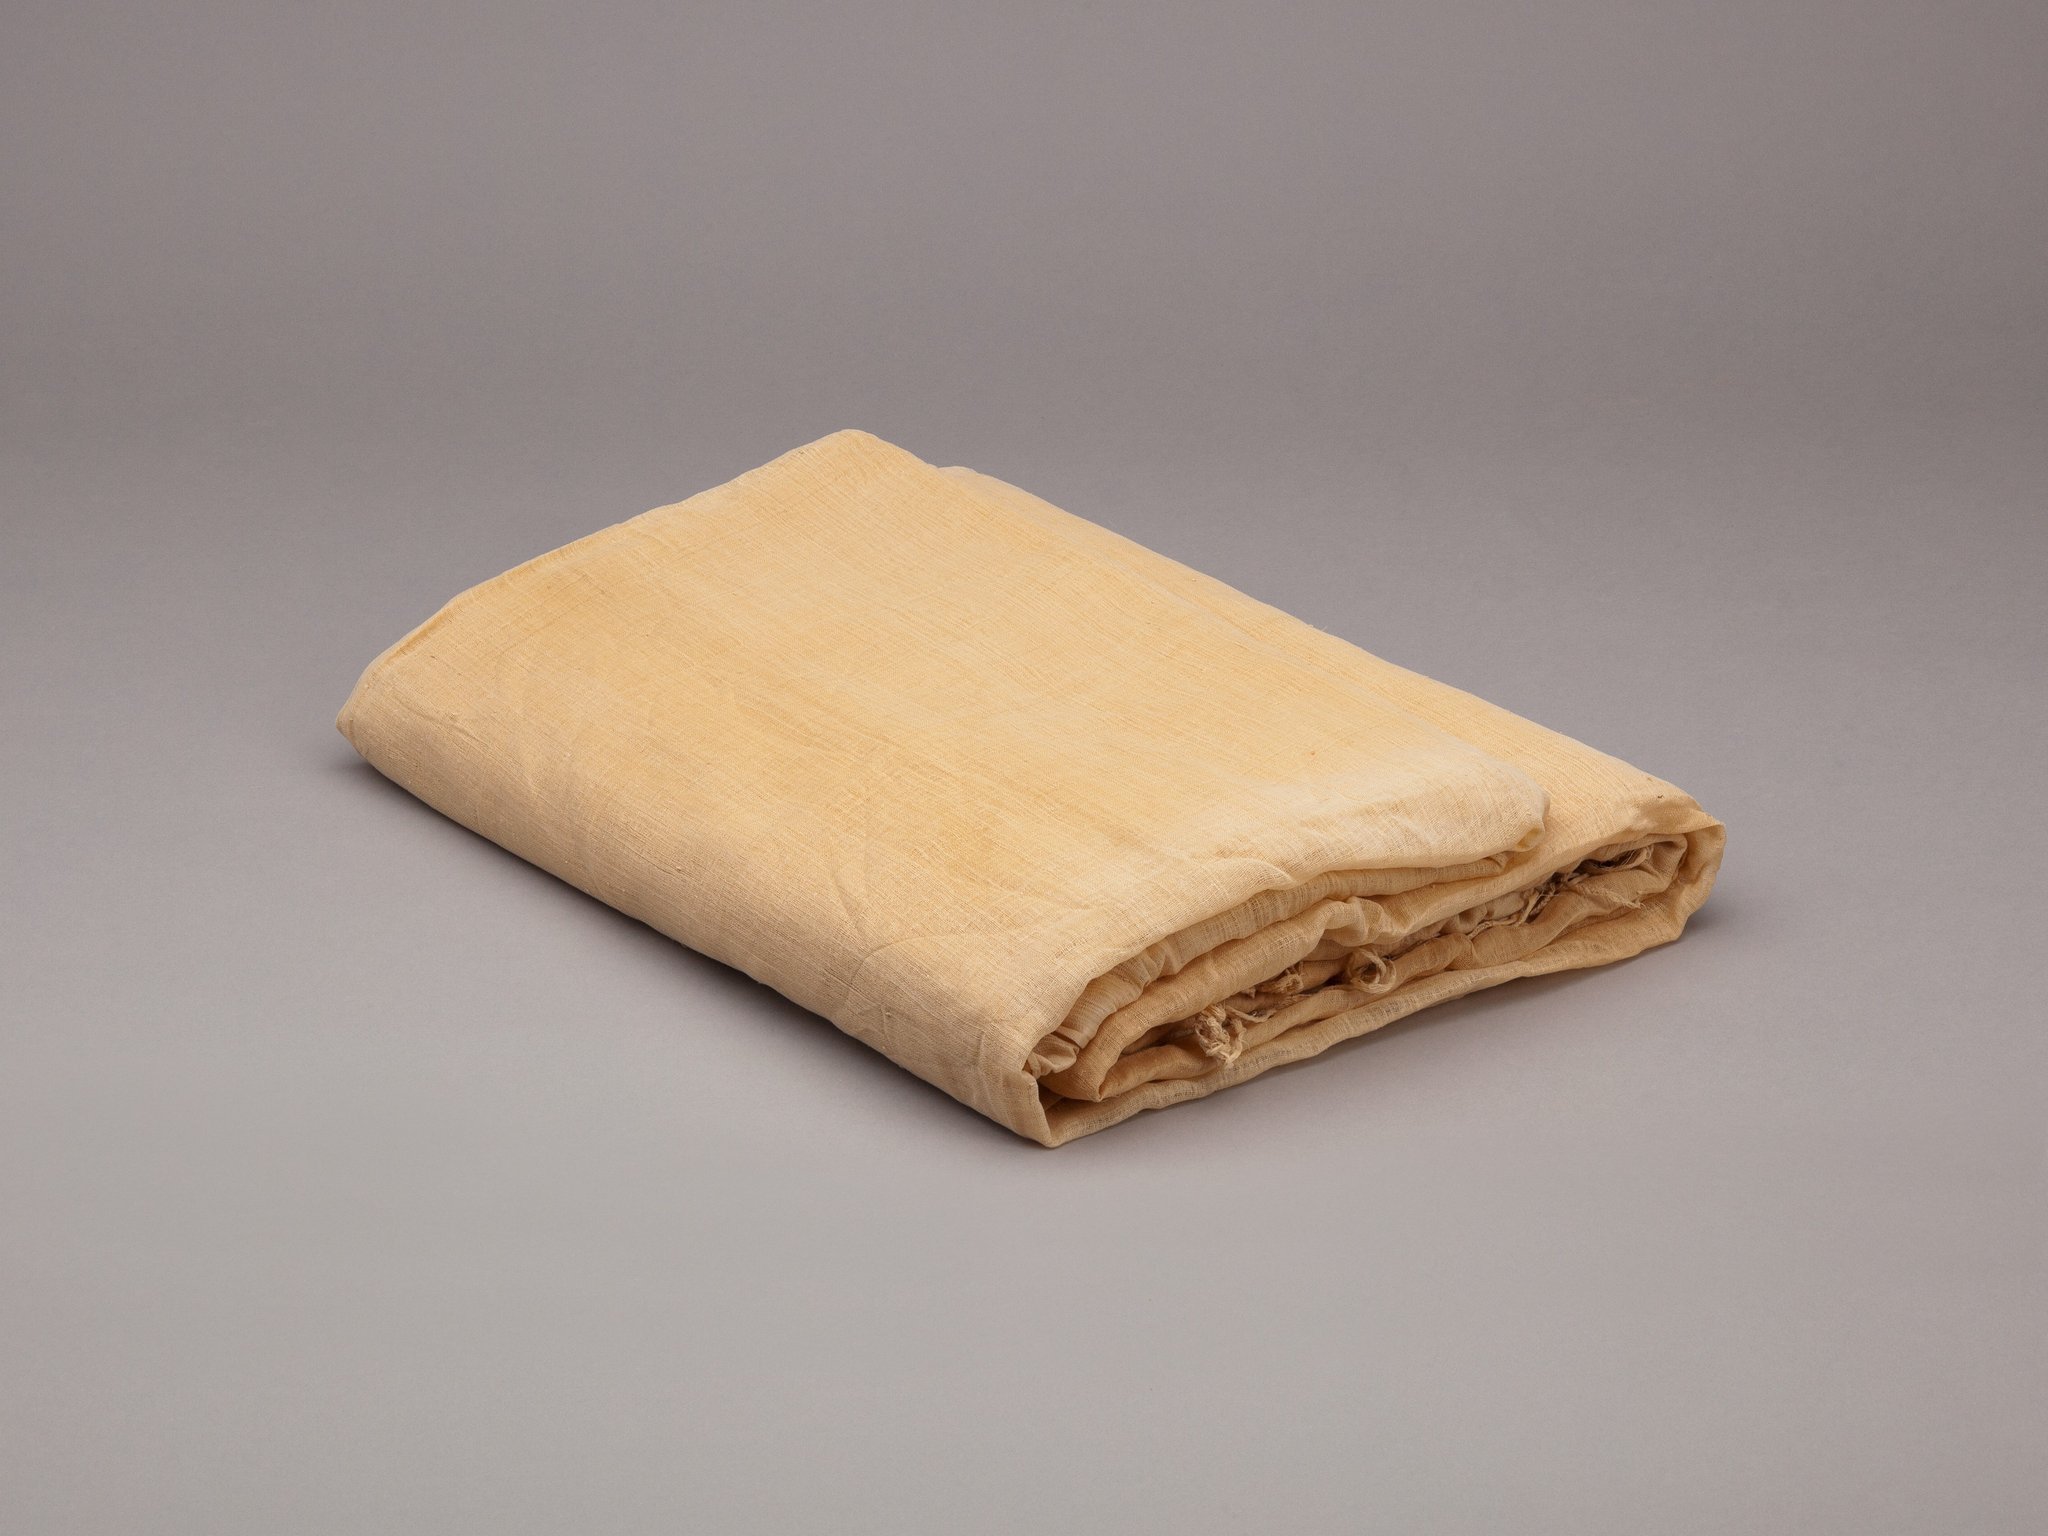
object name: linen mark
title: Sheet, linen mark, fine spin, medium weave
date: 1492-1473 BCE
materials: linen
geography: egypt